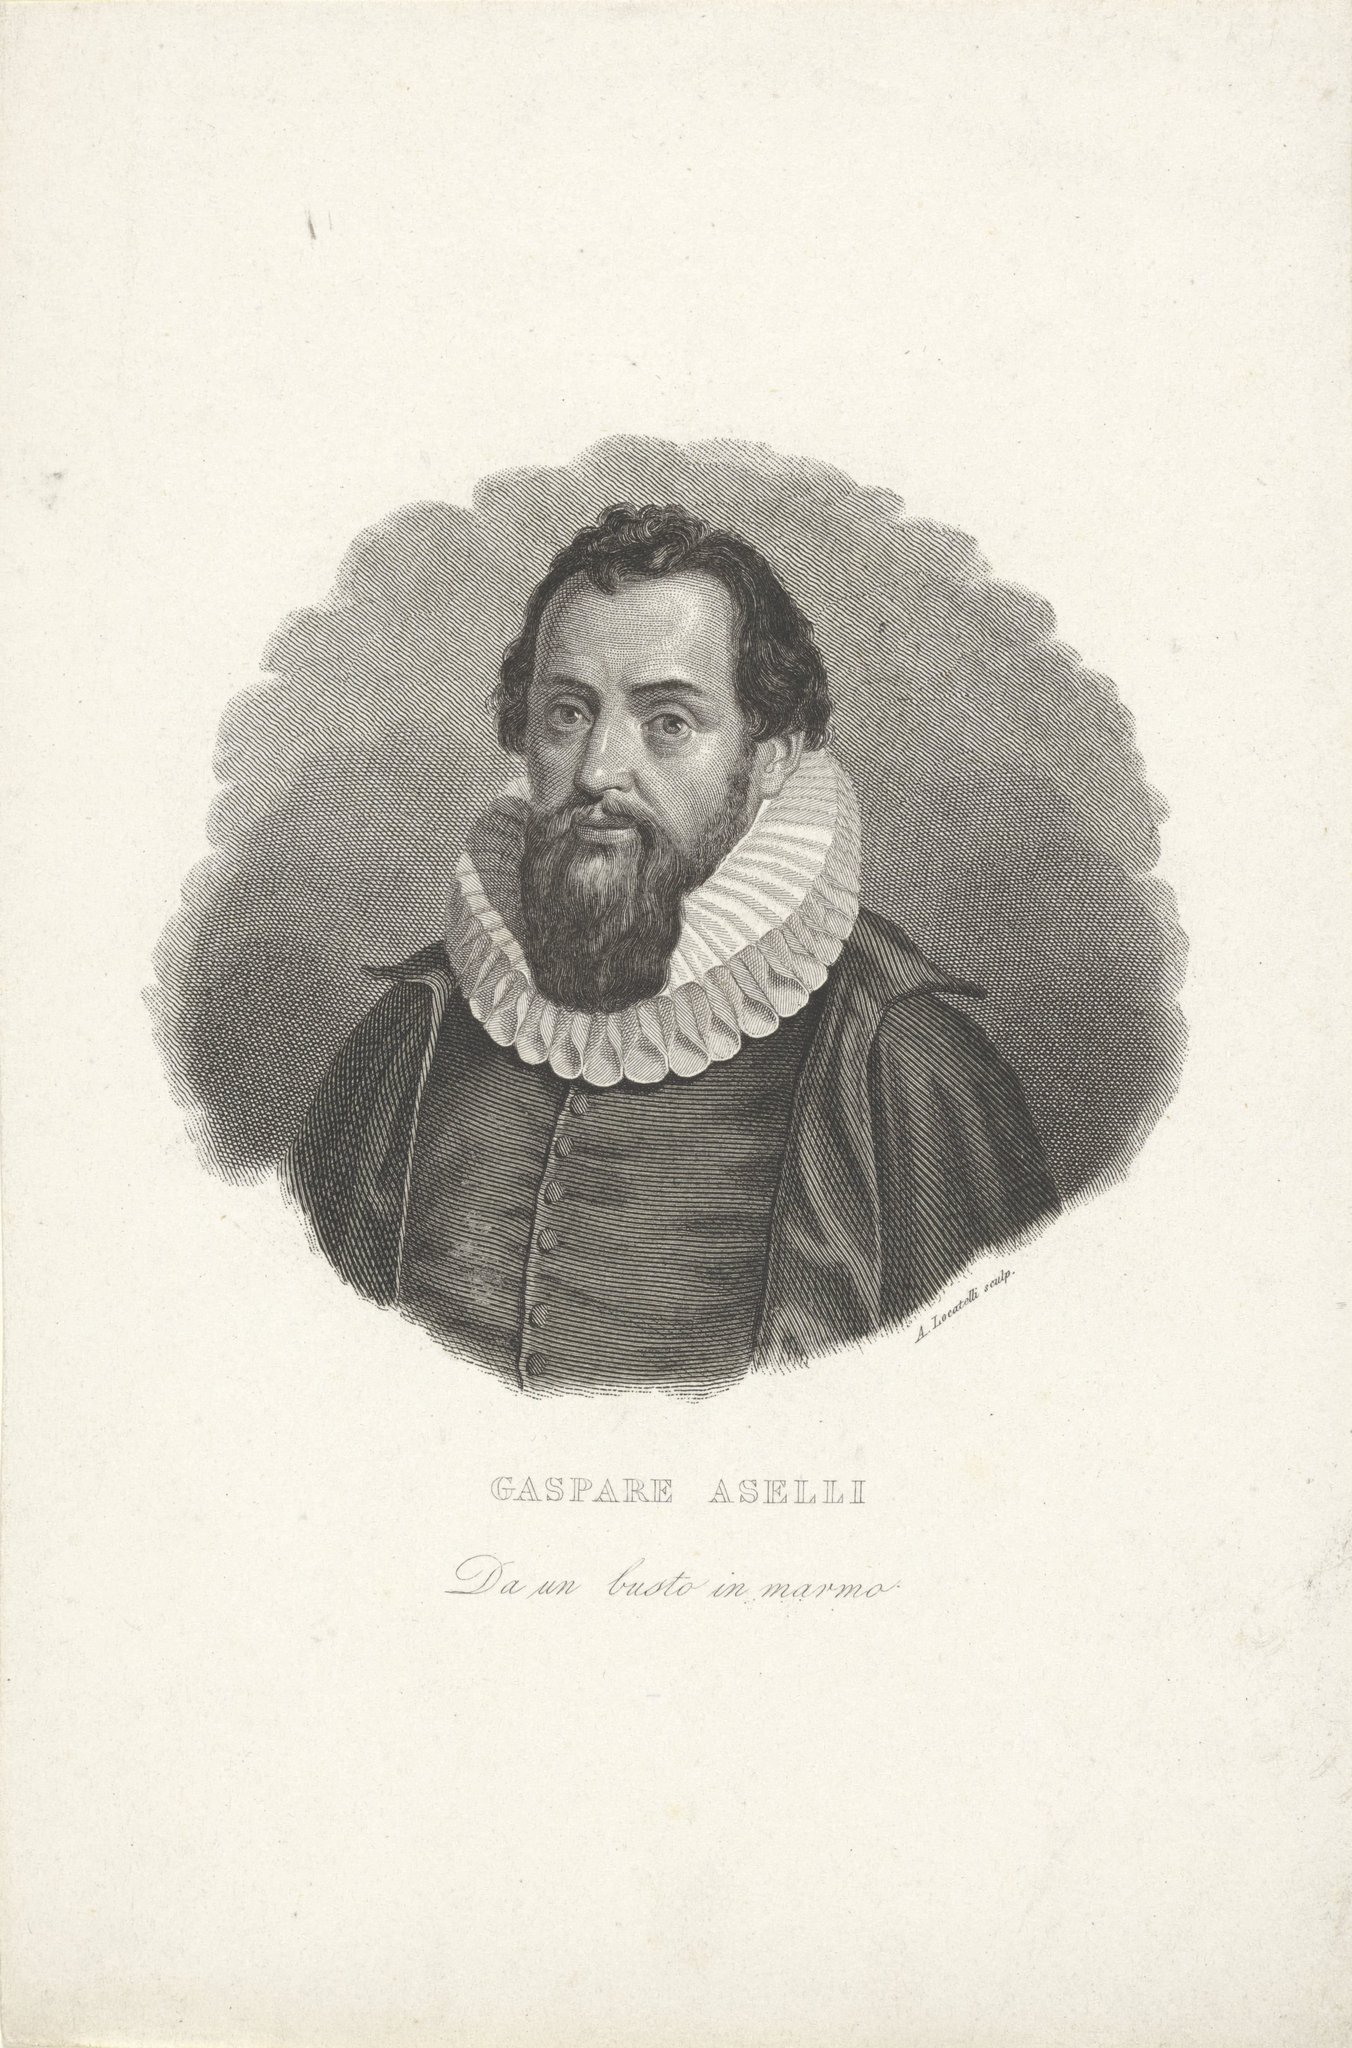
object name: print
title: Portret van arts Gaspare Aselli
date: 1800-1899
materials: paper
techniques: engraving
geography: italy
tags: historical persons, physician, doctor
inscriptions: collector's mark: Lugt 2228